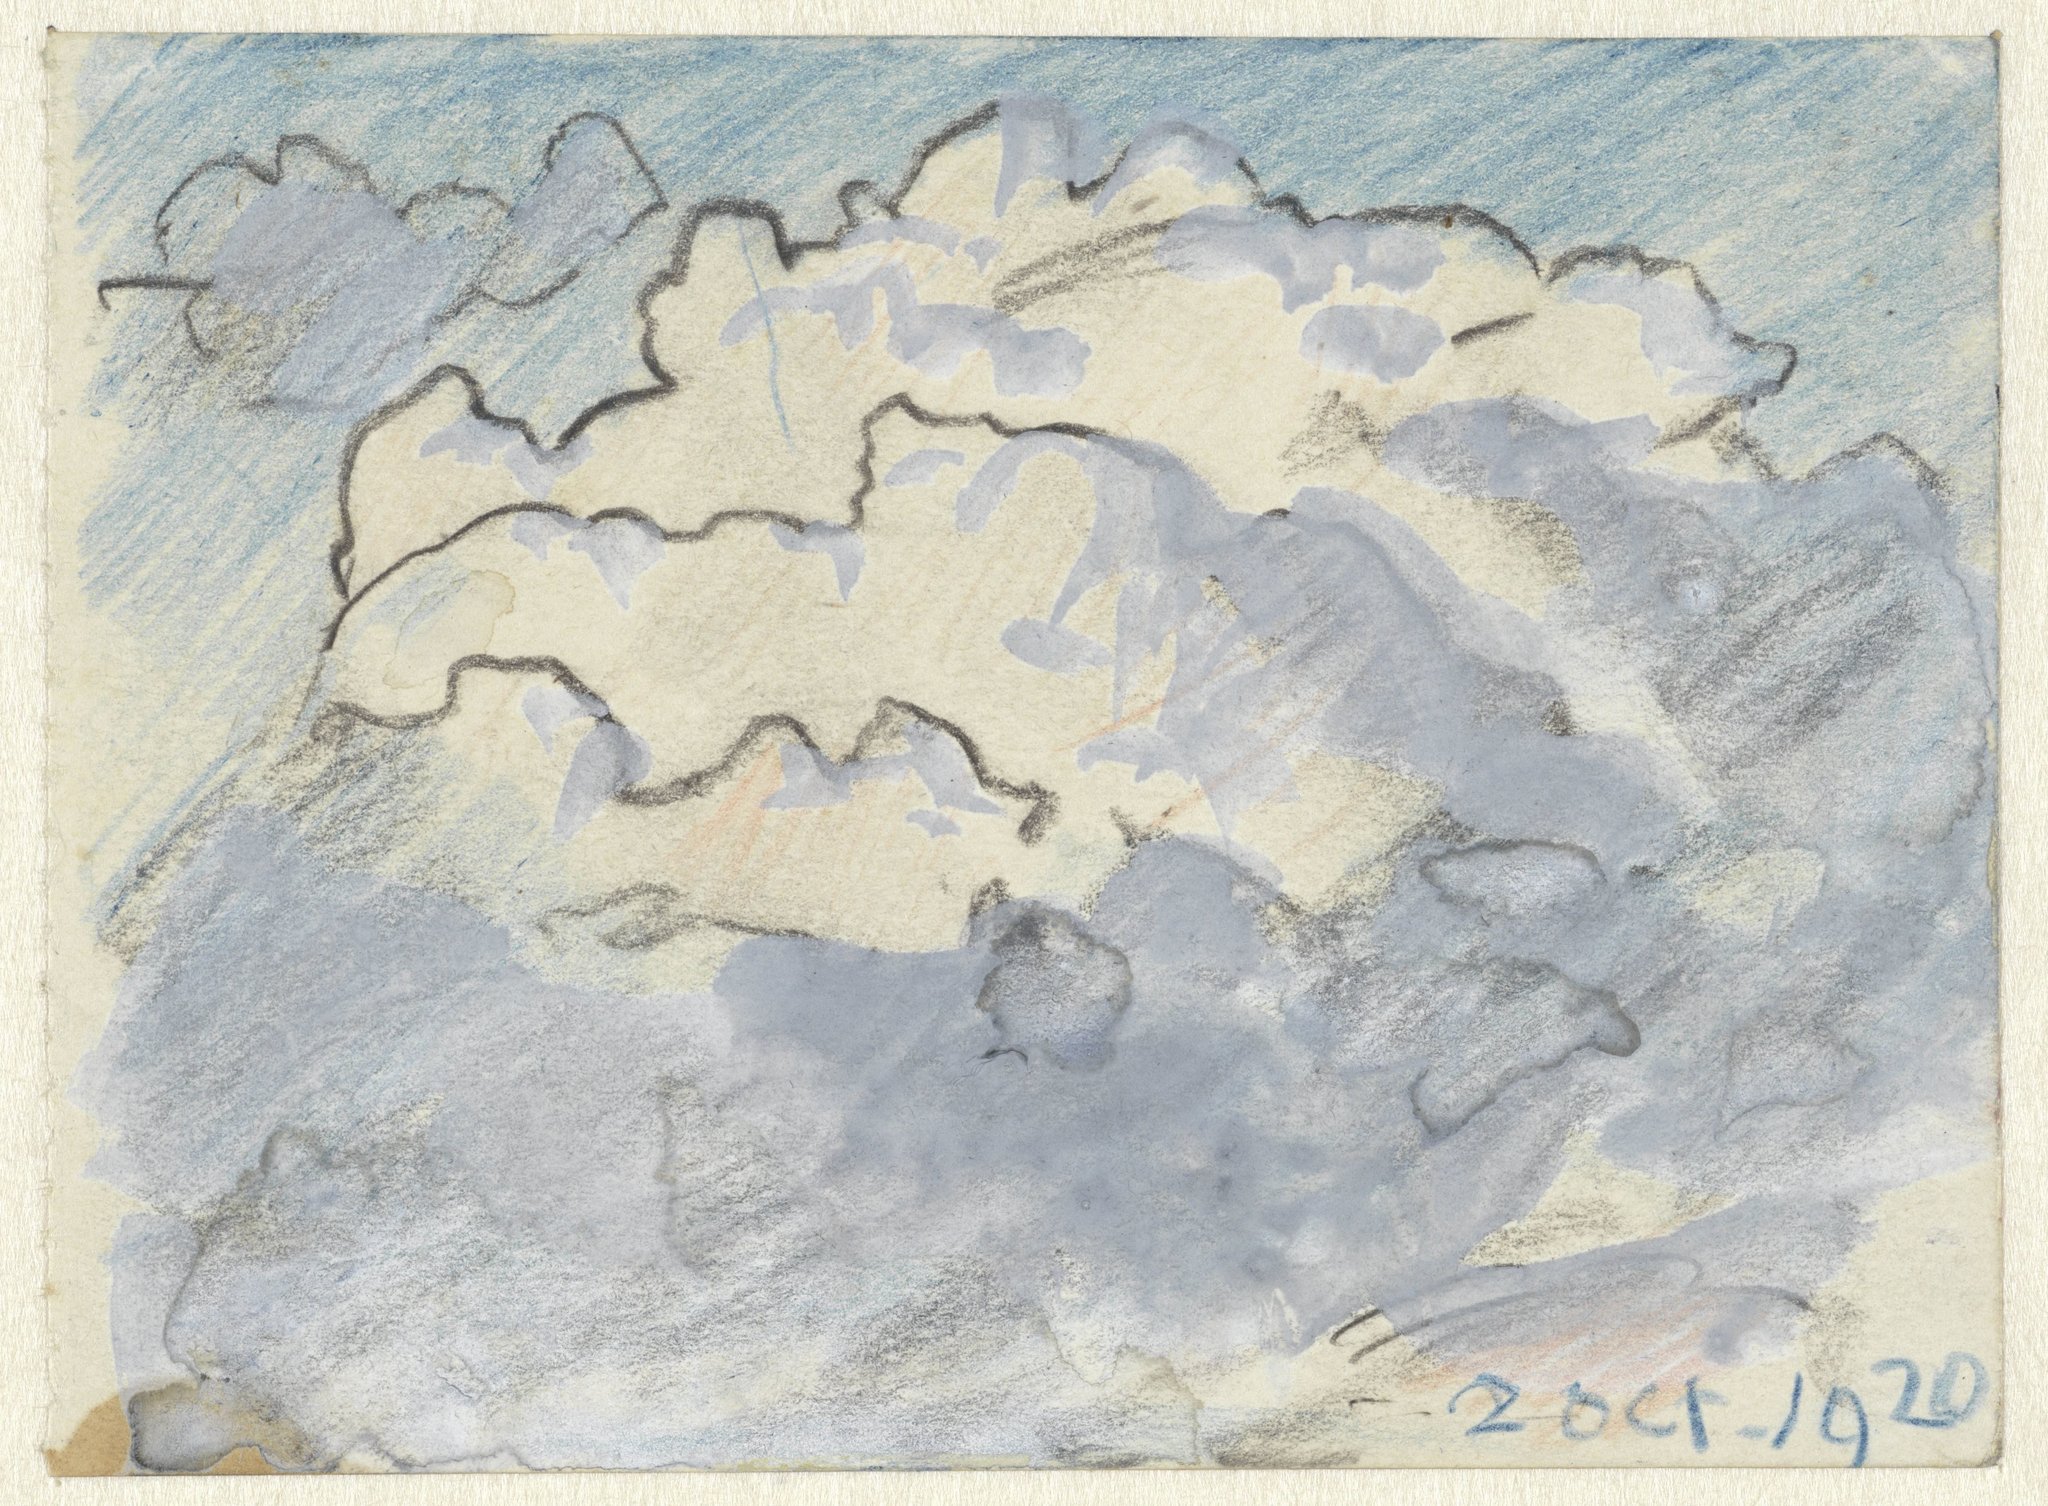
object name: drawing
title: Wolkenstudie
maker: adolf le comte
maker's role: draughtsman, painter, print maker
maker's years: 1850-1921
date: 1920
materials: chalk, paper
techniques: brush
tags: clouds